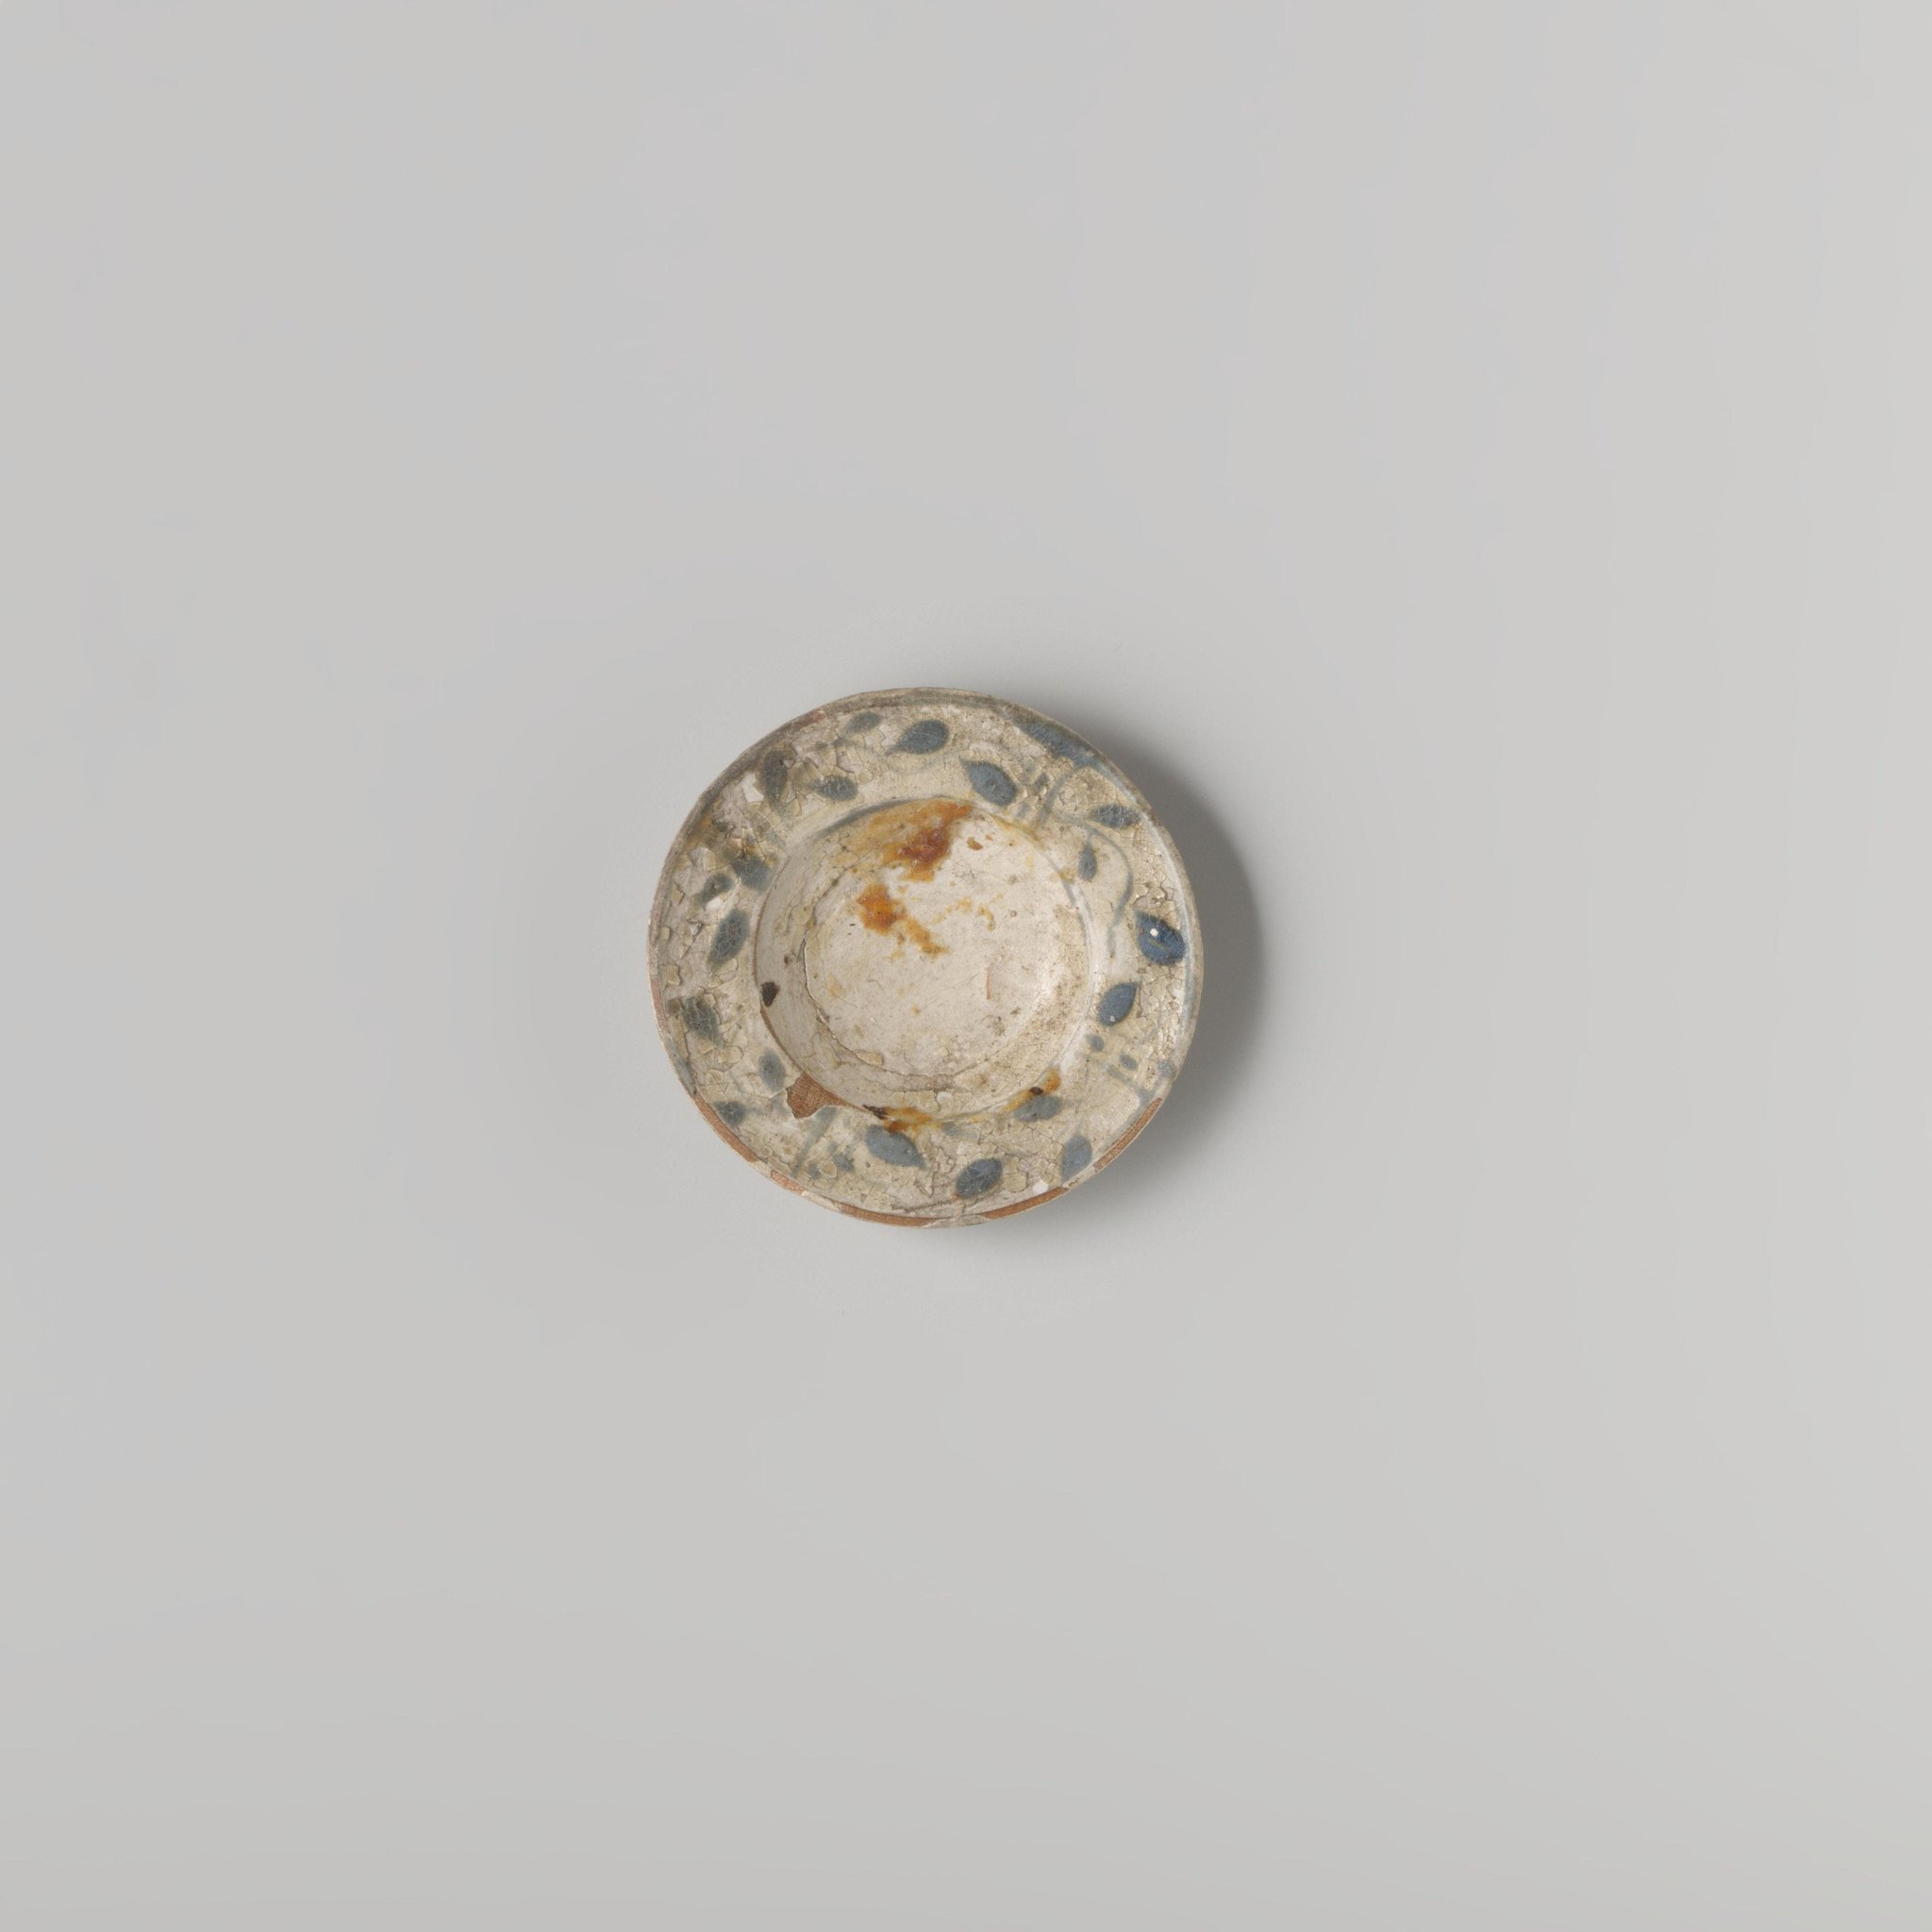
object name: plate dish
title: Bord, gedraaid van hout, beschilderd in blauw op wit met bloemmotieven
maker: Anonymous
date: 1676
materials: wood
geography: amsterdam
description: Bord, gedraaid van hout, beschilderd in blauw op wit met bloemmotieven.